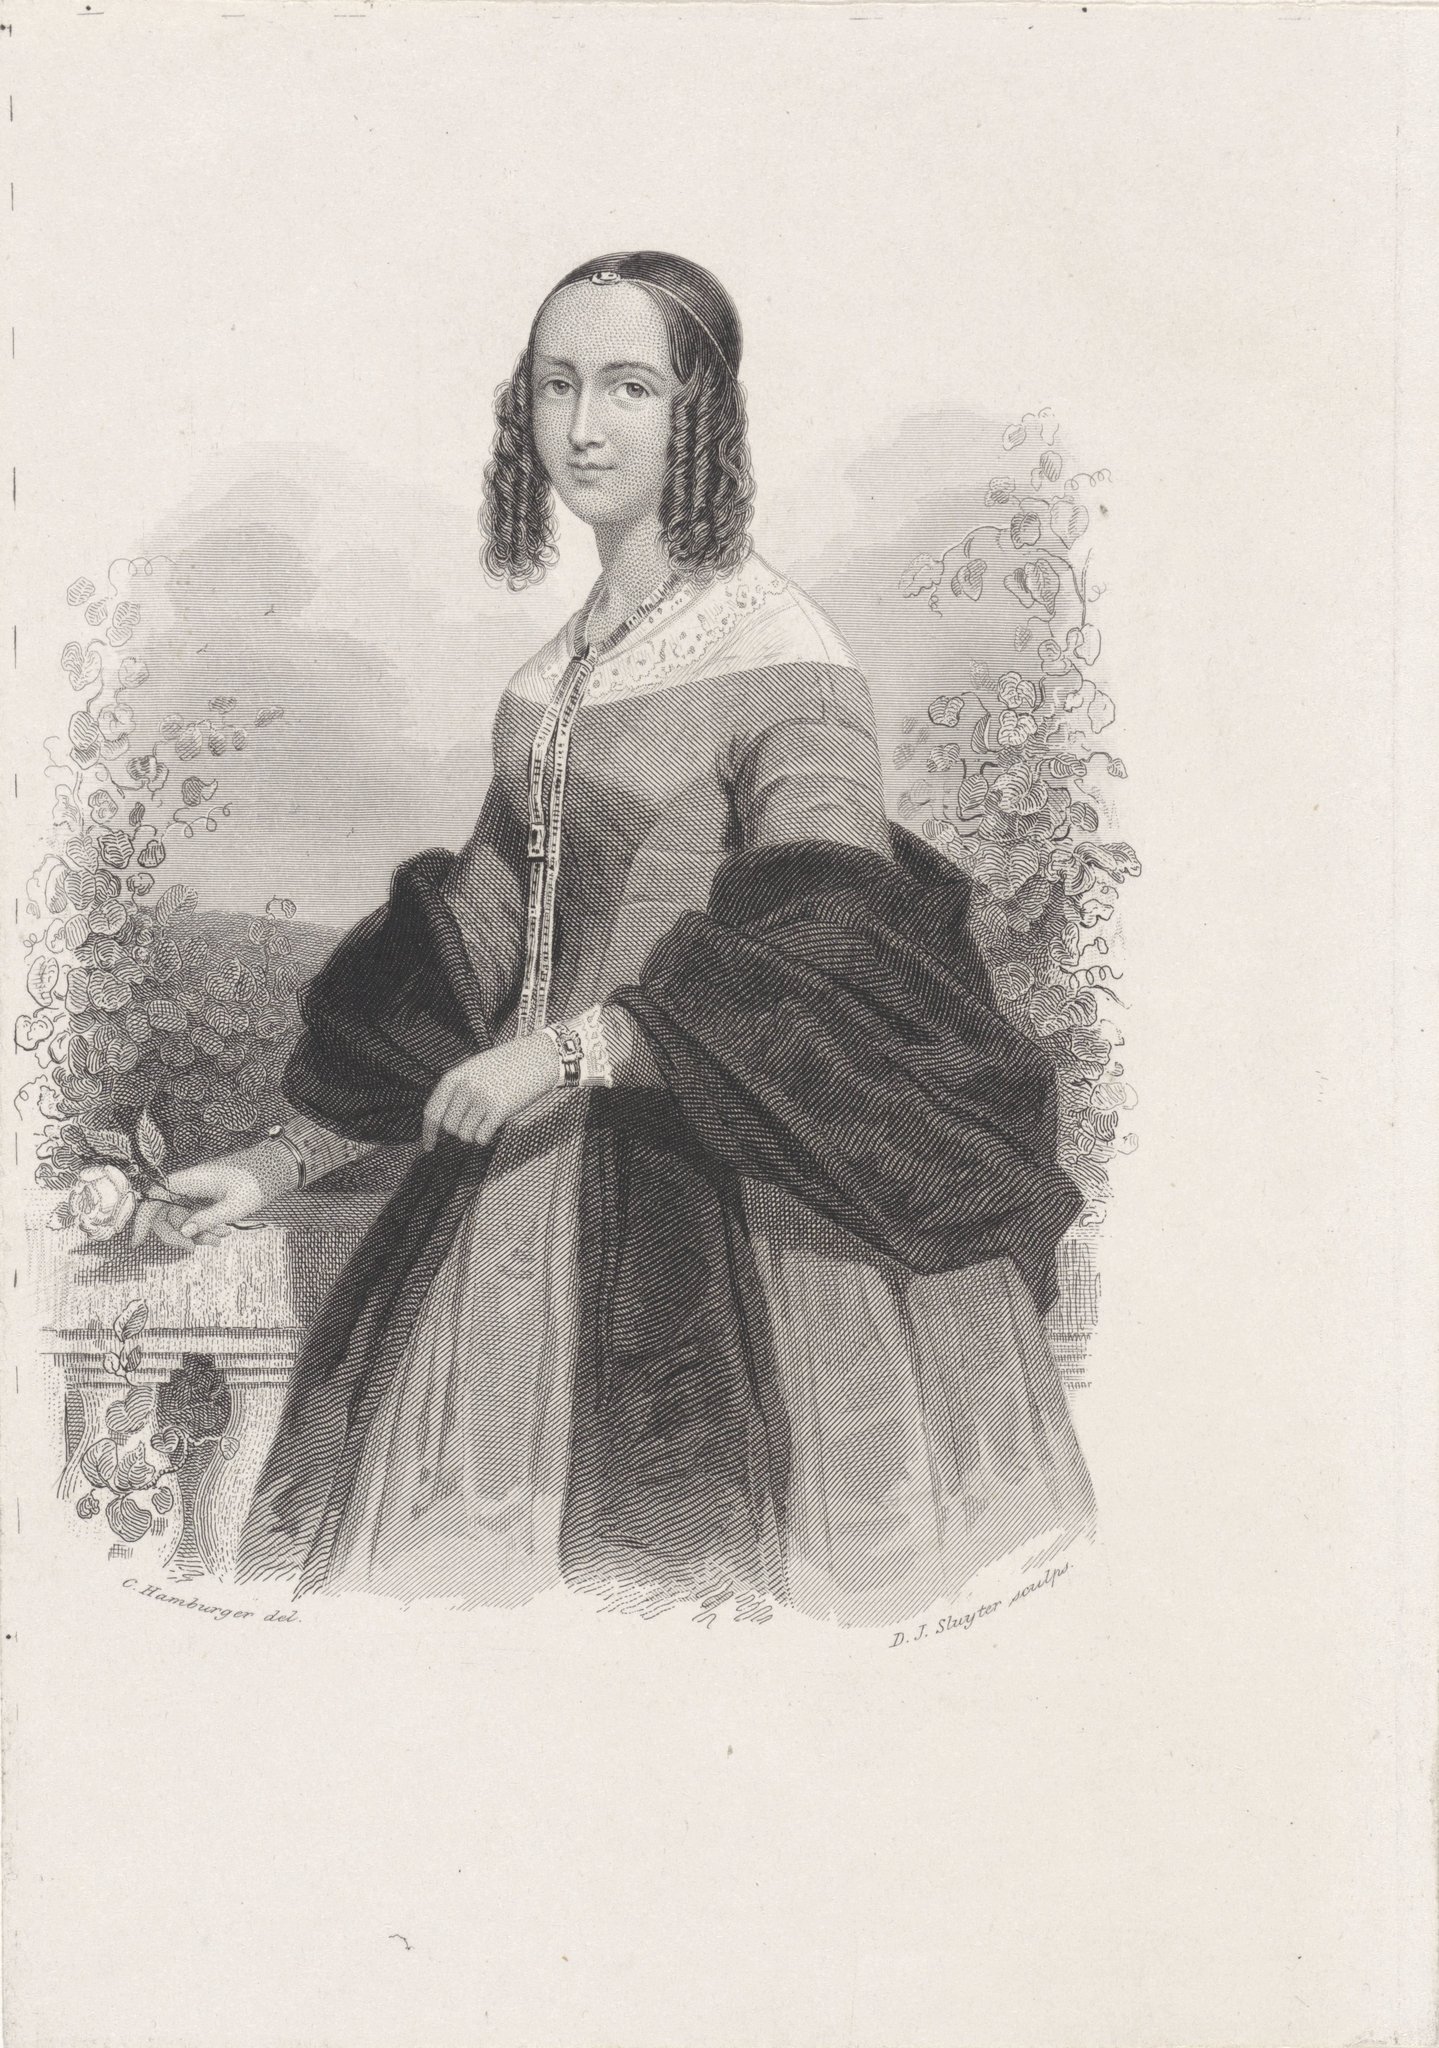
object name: print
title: Vrouw met roos voor balustrade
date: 1826-1886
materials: paper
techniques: engraving, etching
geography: amsterdam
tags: adolescent, young woman, maiden (+ three-quarter view), flowers: rose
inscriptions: collector's mark: Lugt 2228